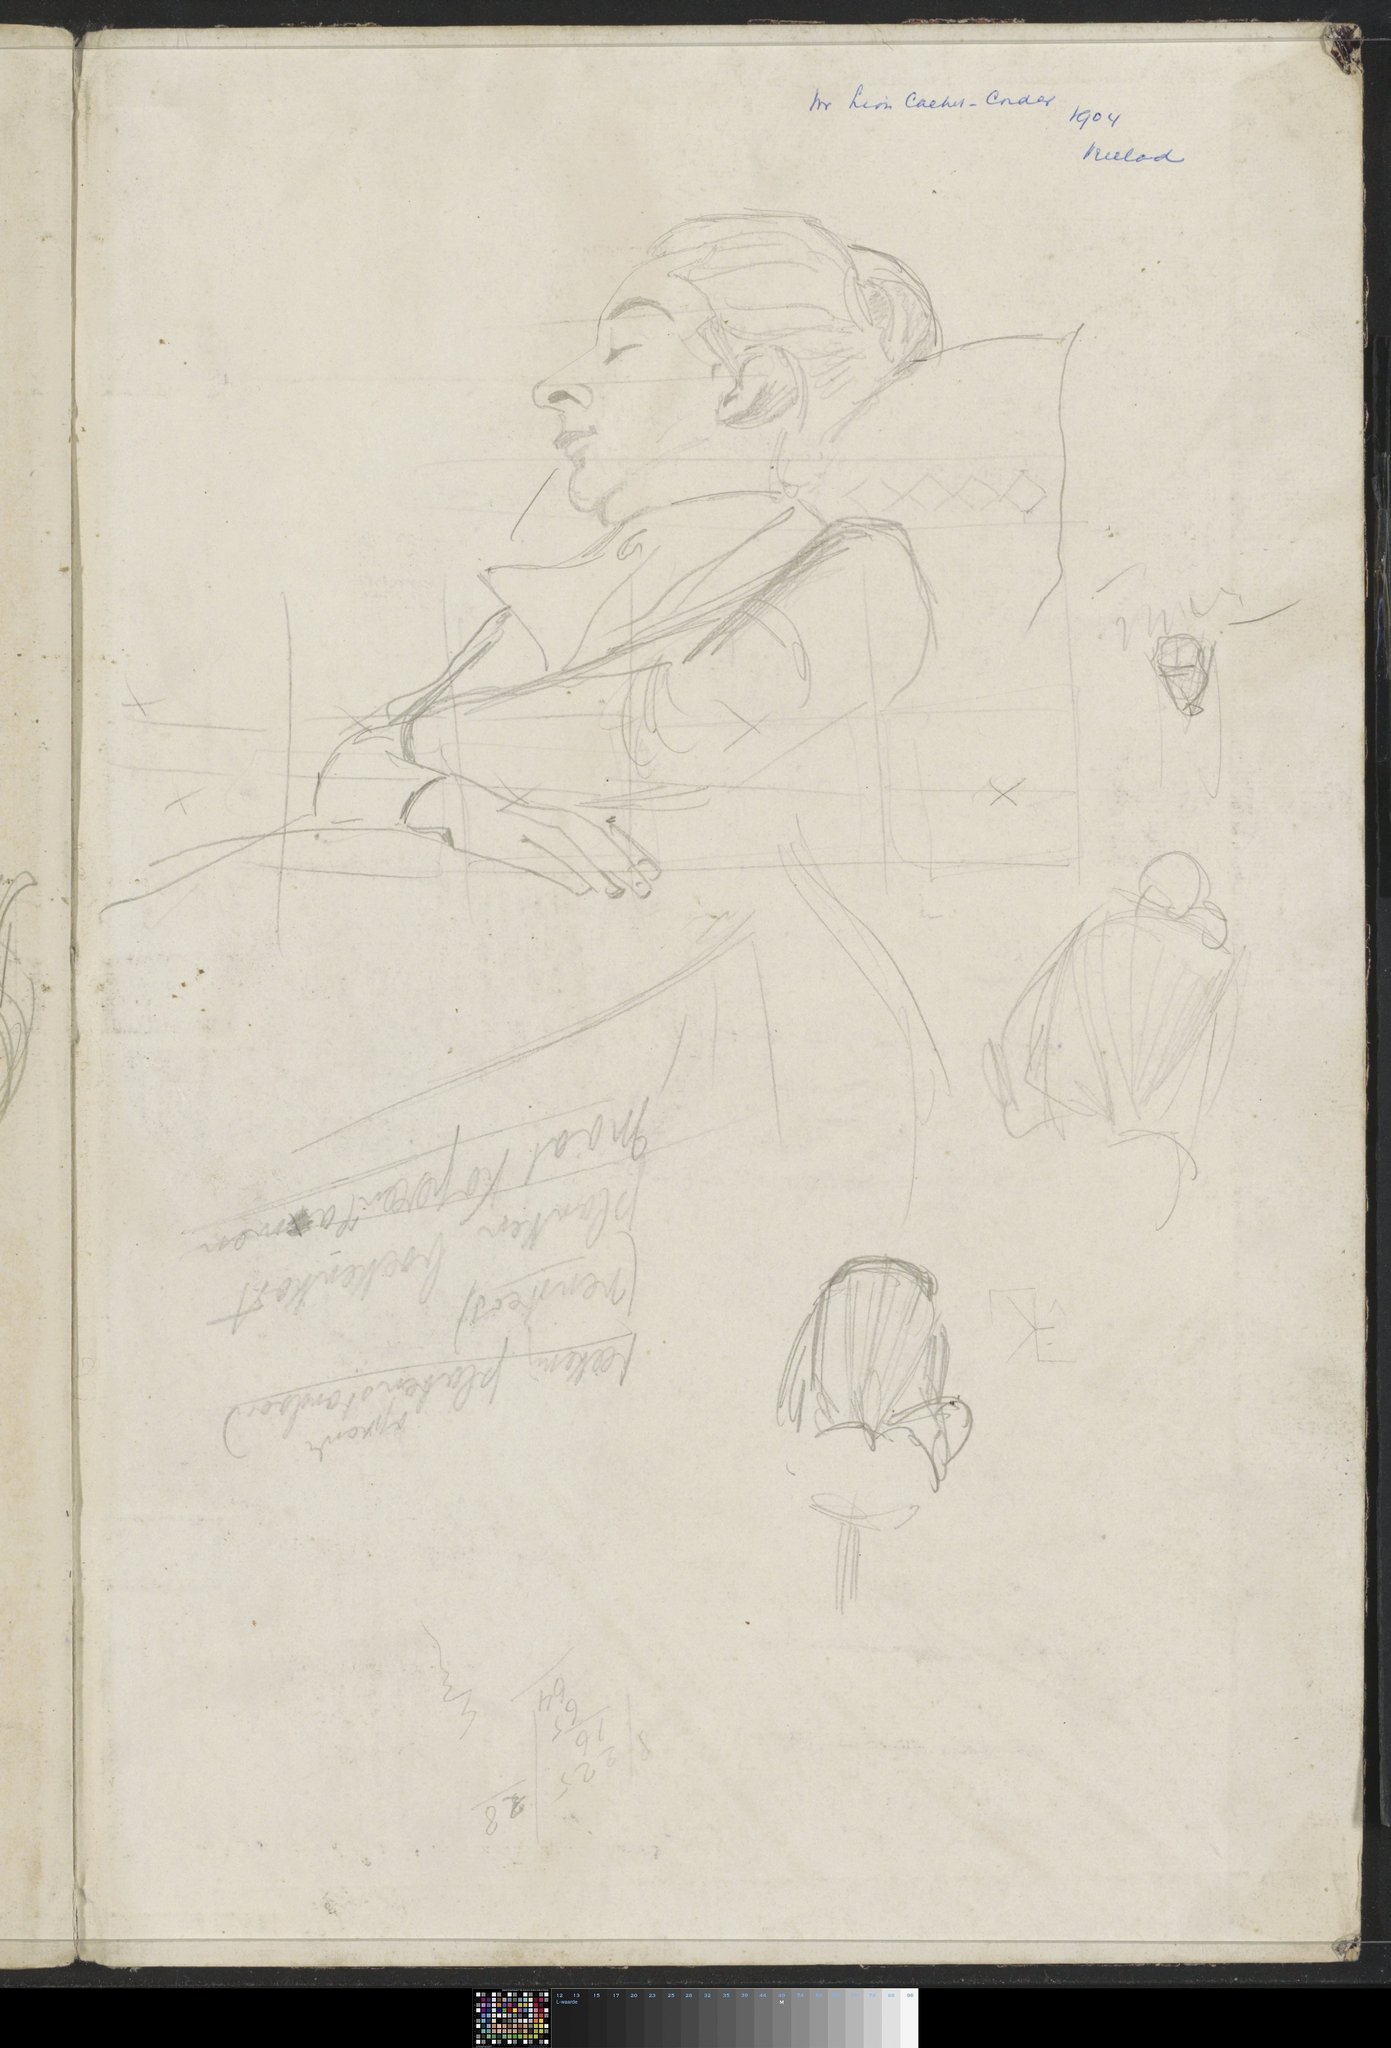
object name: endleaf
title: Portret van een slapende vrouw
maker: carel adolph lion cachet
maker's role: draughtsman, print maker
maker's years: 1864-1945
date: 1903-1904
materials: paper, pencil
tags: sleeping in chair, adult woman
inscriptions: date and inscription: ‘Mw Lion Cachet-Cordes/ 1904/ Vreeland’, annotation: ‘teekeni[...] platen[...]standaard/ (vensters)/ planken boekenkast/ maa[...] koperen ramen’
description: Achterste schutblad uit een schetsboek met 17 bladen.